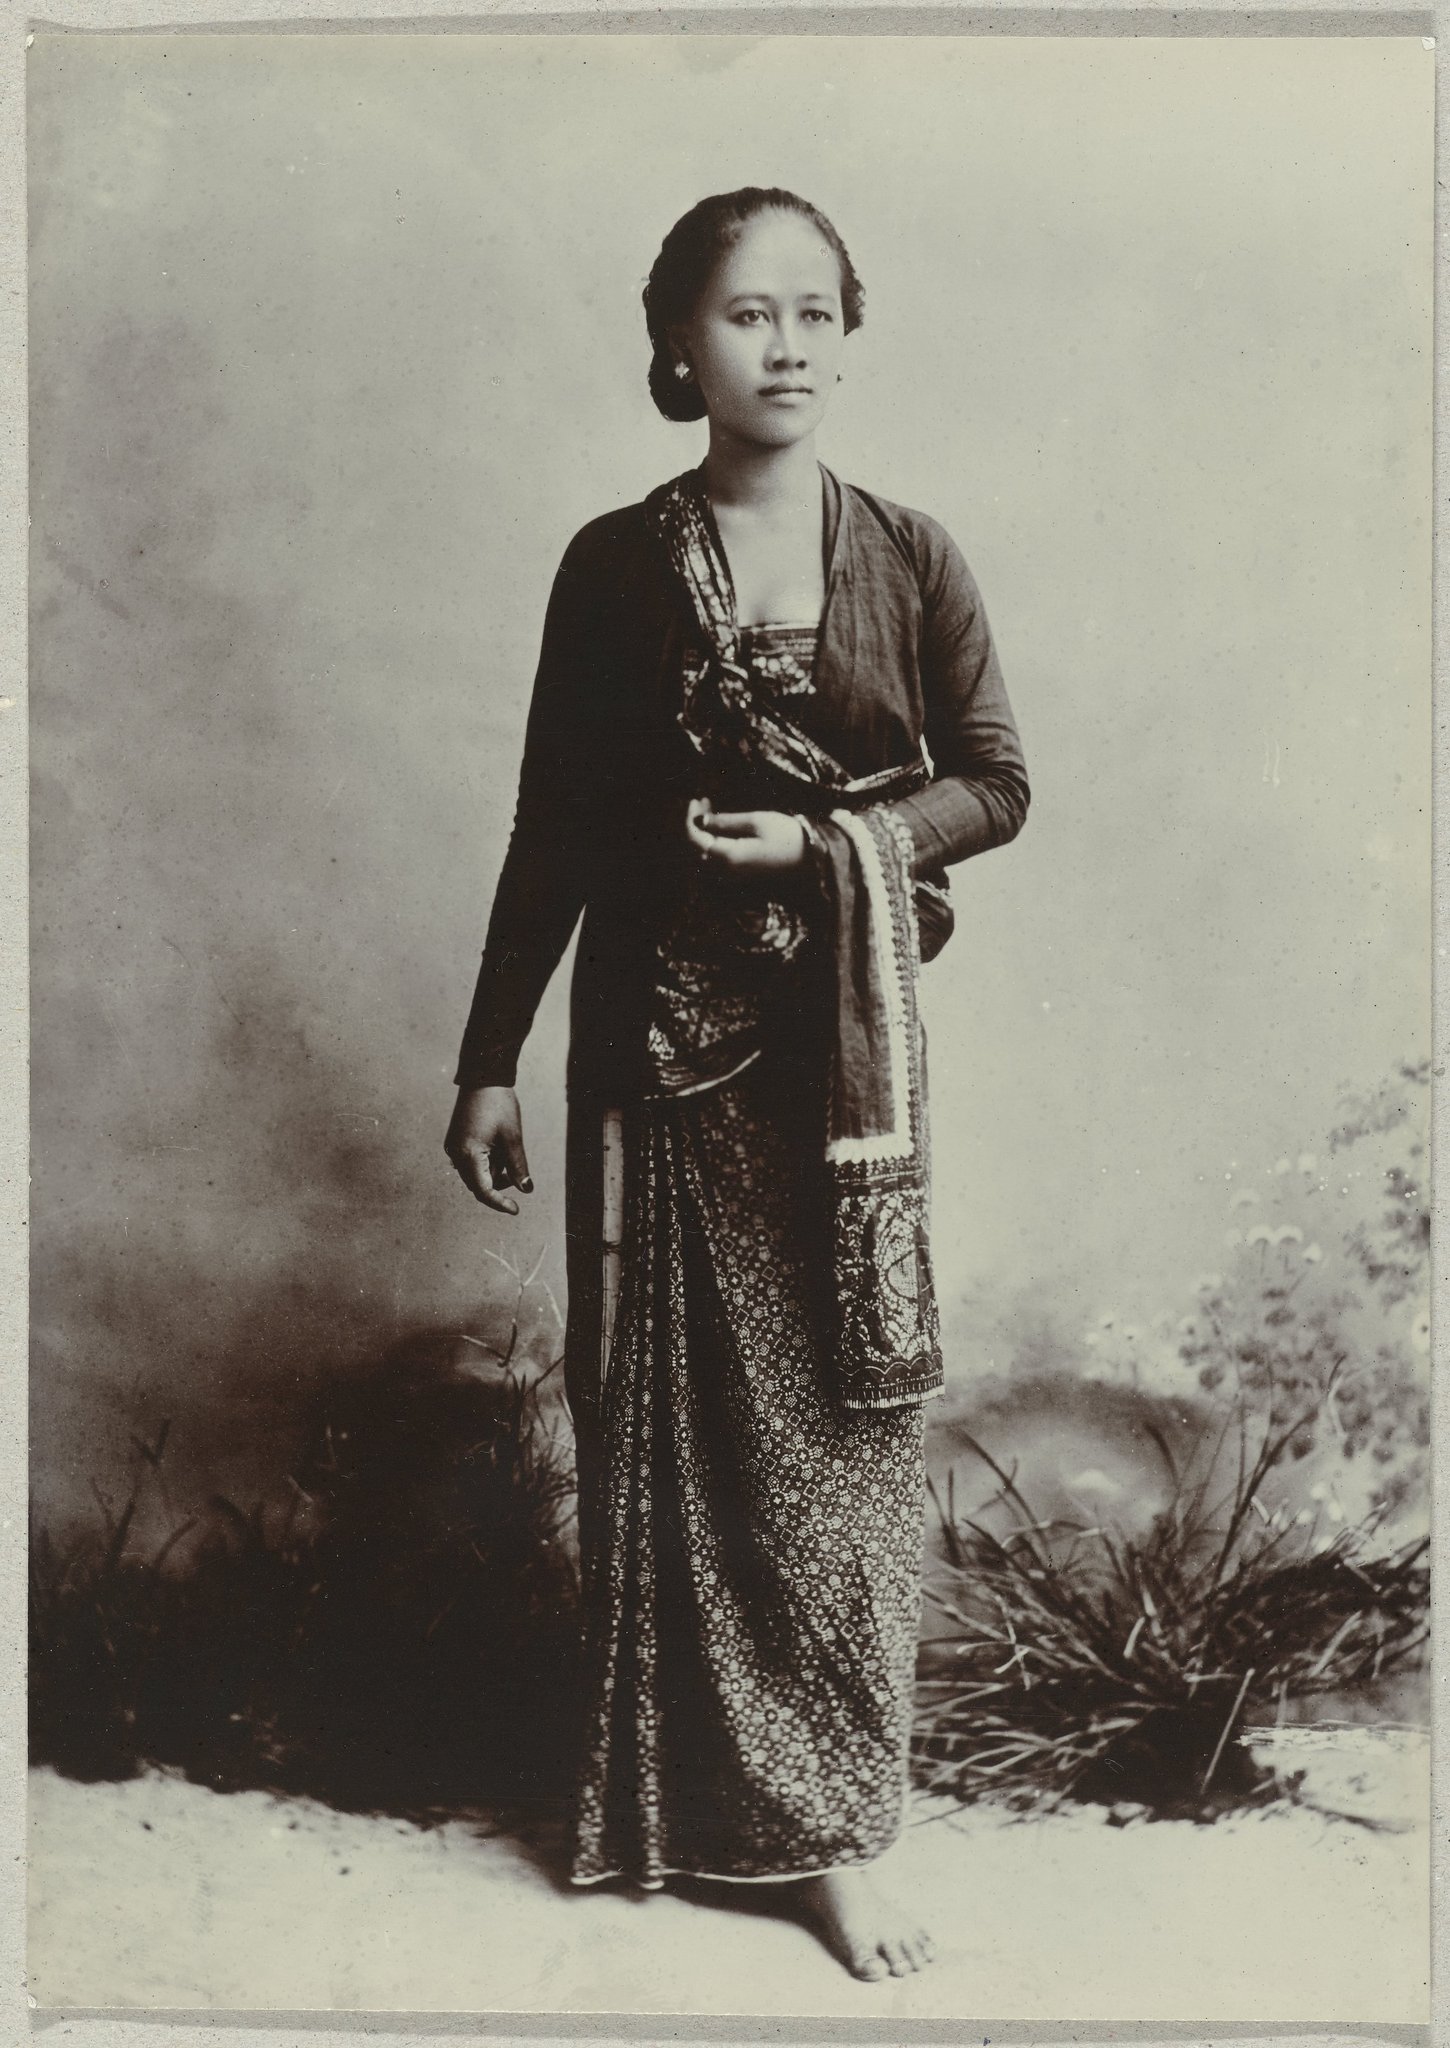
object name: photograph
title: Studioportret van een jonge Javaanse vrouw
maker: kassian céphas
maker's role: fotograaf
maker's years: 1845-1912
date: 1870-1912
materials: cardboard, paper, photographic support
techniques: albumen print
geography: java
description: Studioportret van een jonge Javaanse vrouw. Zij draag een batik sarong en staat op blote voeten.